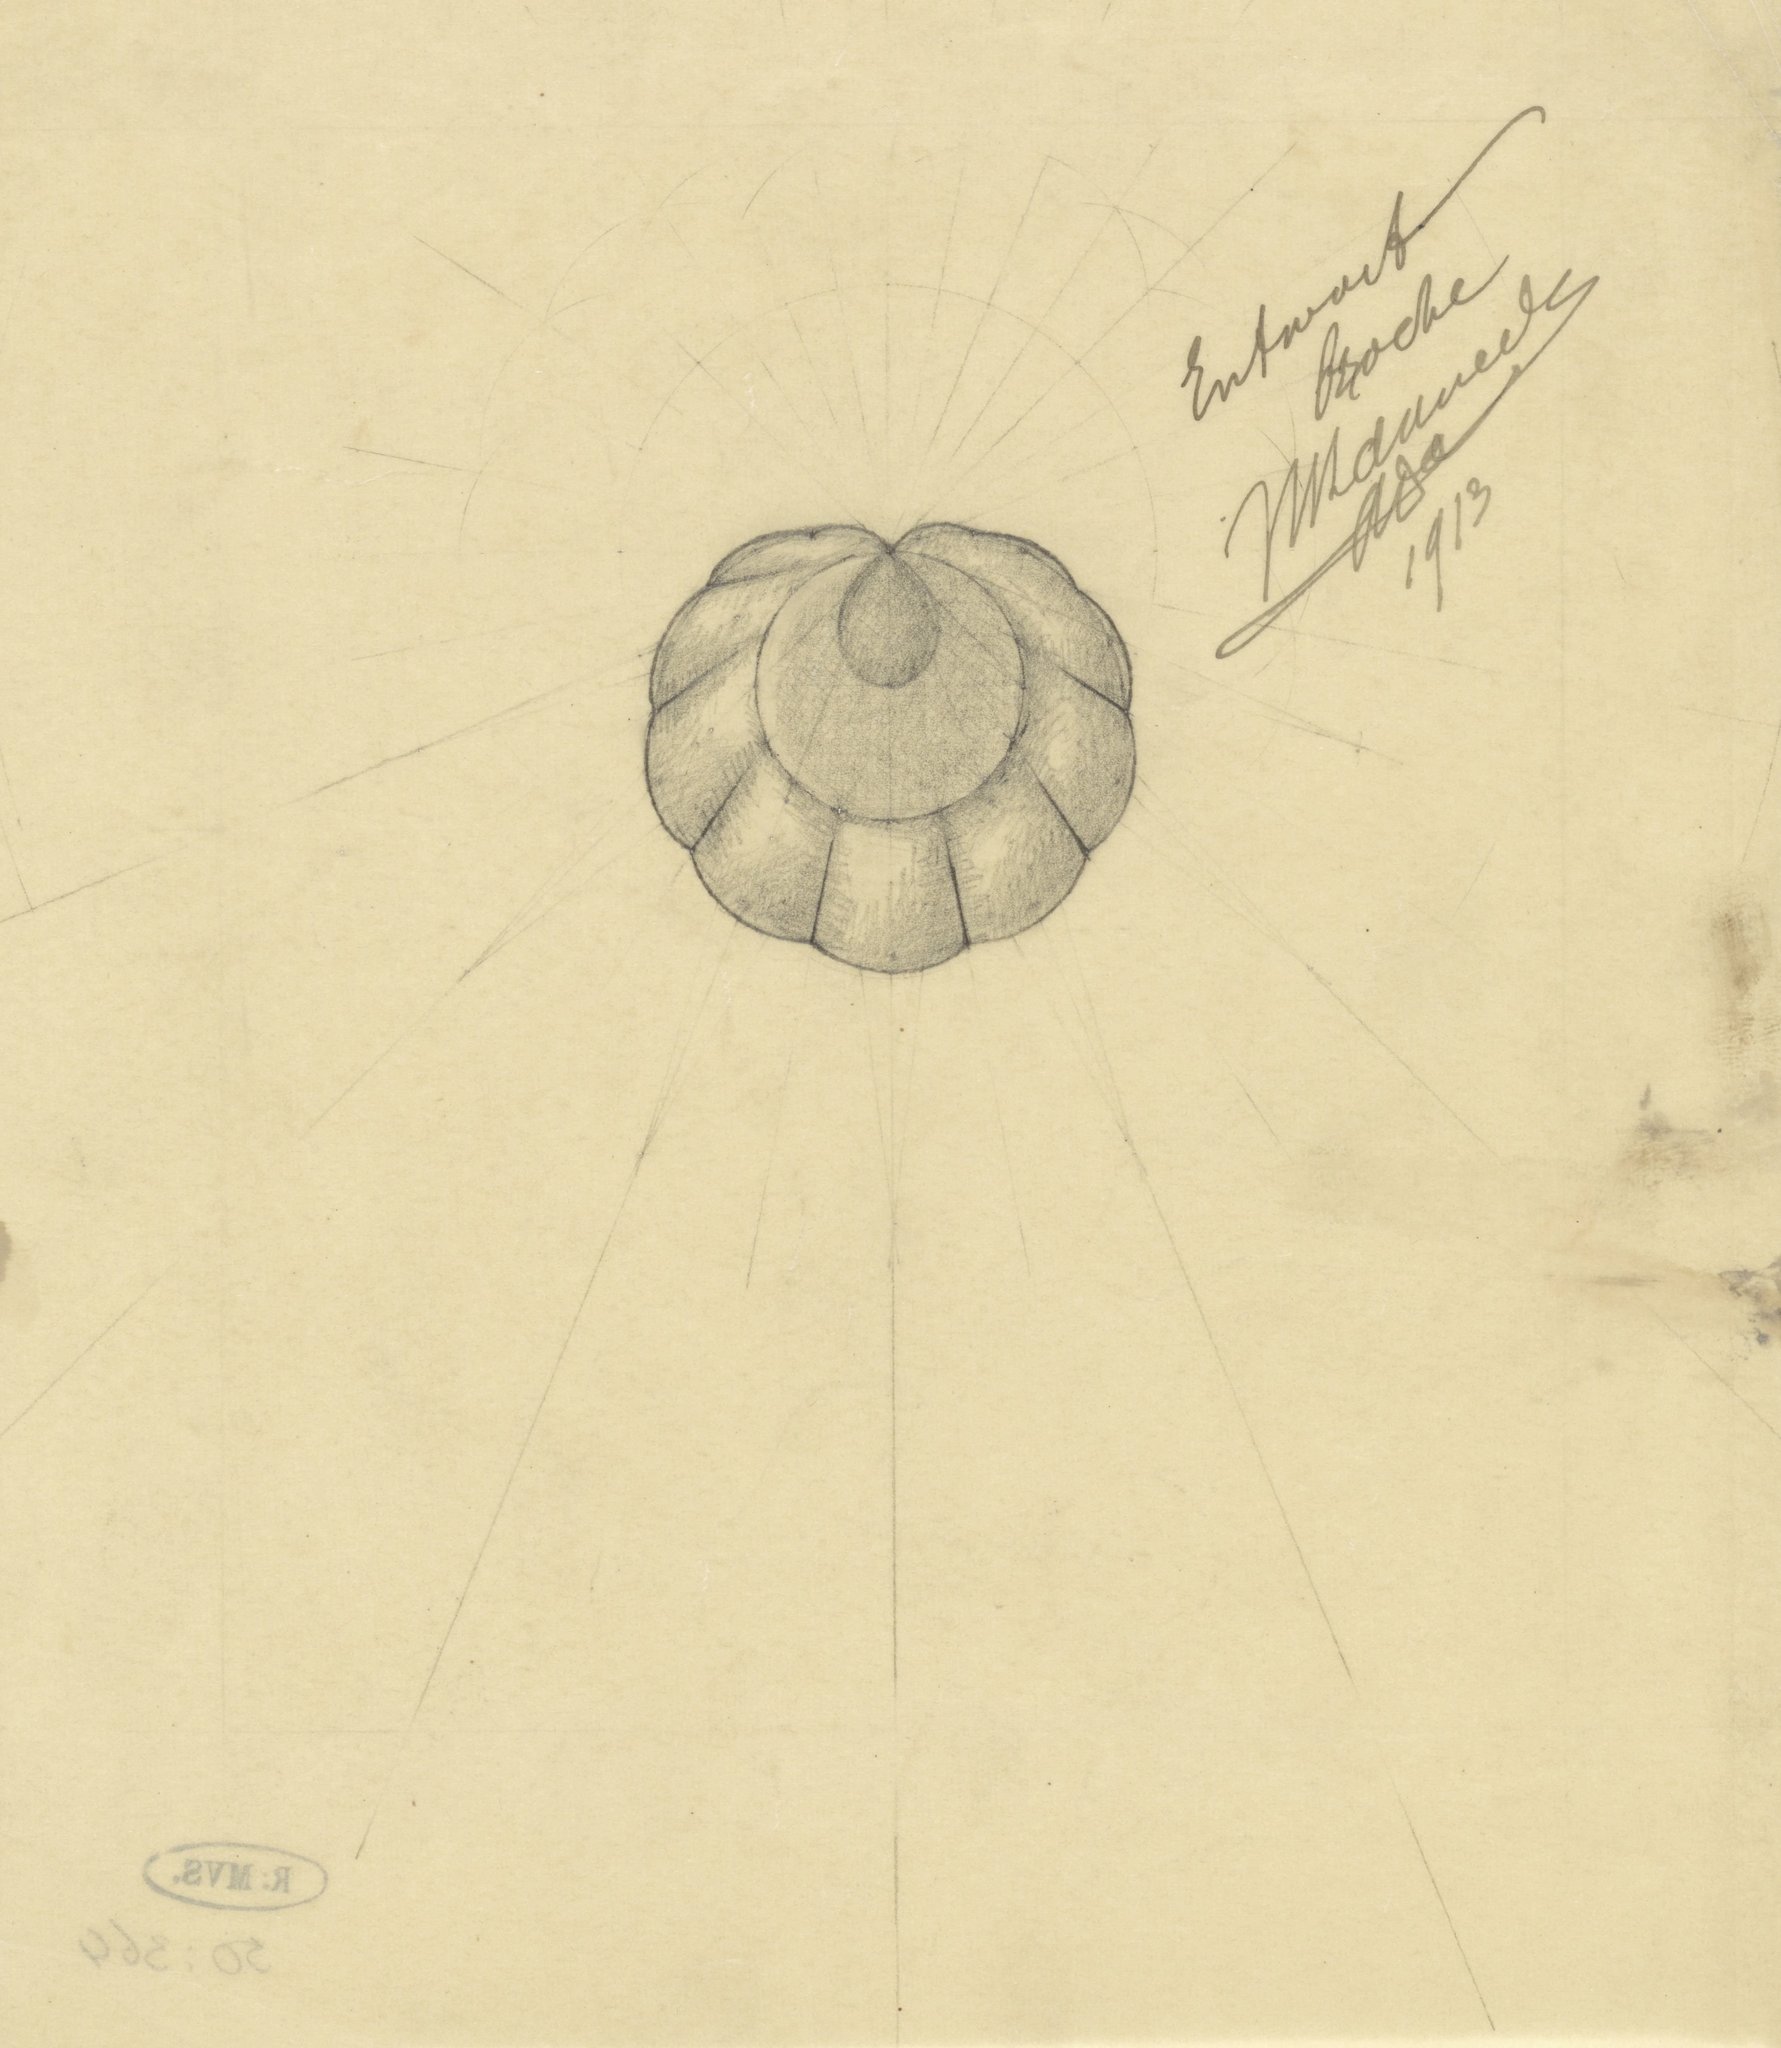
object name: drawing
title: Ontwerp voor een broche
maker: mathieu lauweriks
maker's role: designer, draughtsman, print maker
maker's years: 1864-1932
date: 1913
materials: pencil, paper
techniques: pricking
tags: brooch, agraffe, clasp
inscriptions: date